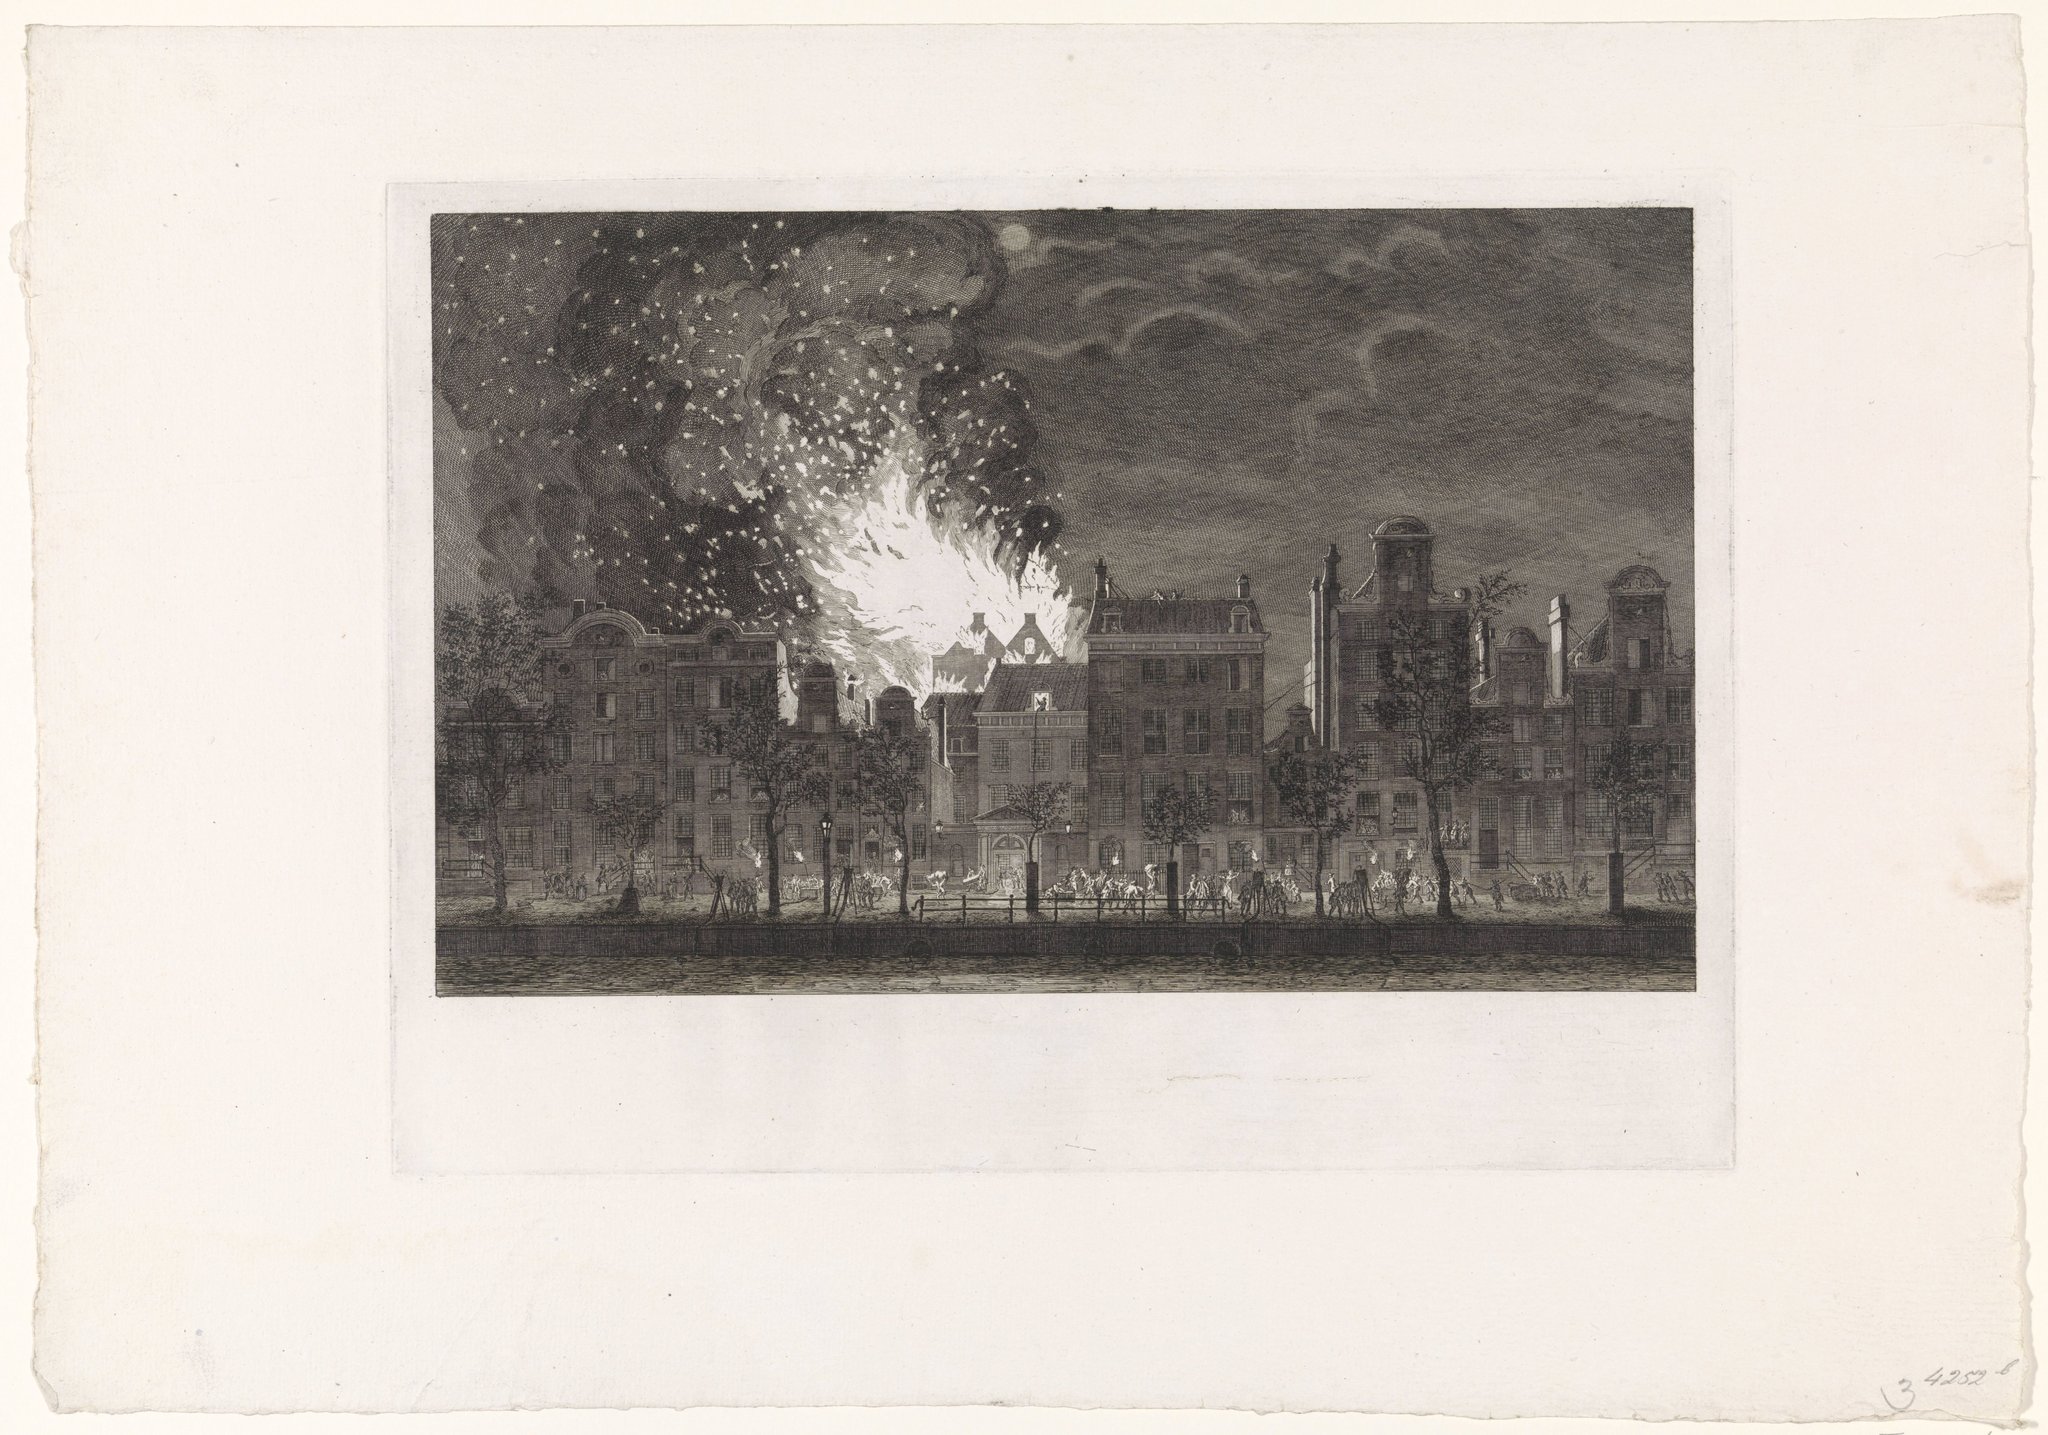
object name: print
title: De brand in de Amsterdamse Schouwburg, 1772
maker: cornelis bogerts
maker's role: print maker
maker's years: 1745-1817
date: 1772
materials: paper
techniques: engraving, etching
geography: northern netherlands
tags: on fire, ablaze, theatre, theatrical performance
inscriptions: collector's mark: Lugt 2228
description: Gezicht op de laaiende brand in de Amsterdamse Schouwburg, gezien vanaf de overzijde van de Keizersgracht. De brandweer brengt brandspuitpompen in gereedheid. Onderdeel van een serie van vier prenten met titelprent over de brand in de Amsterdamse Schouwburg.